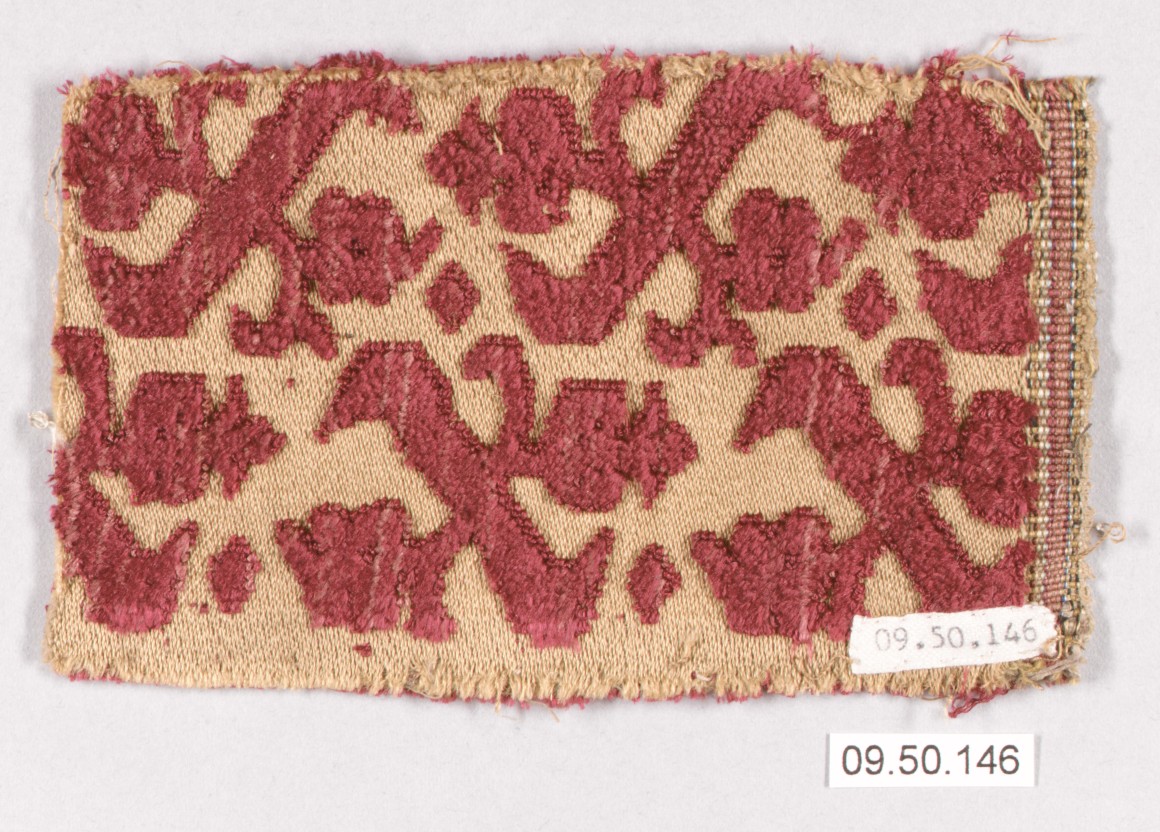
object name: piece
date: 1501-1700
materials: silk